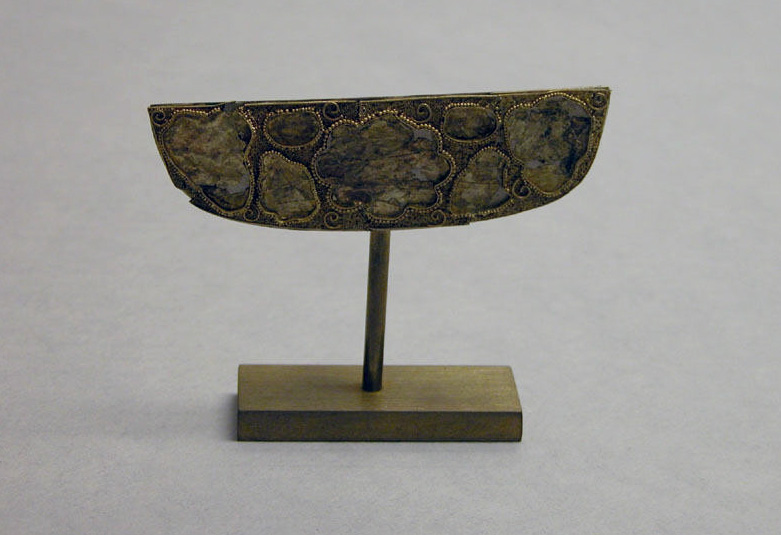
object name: ornament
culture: chinese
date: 618-907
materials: gold